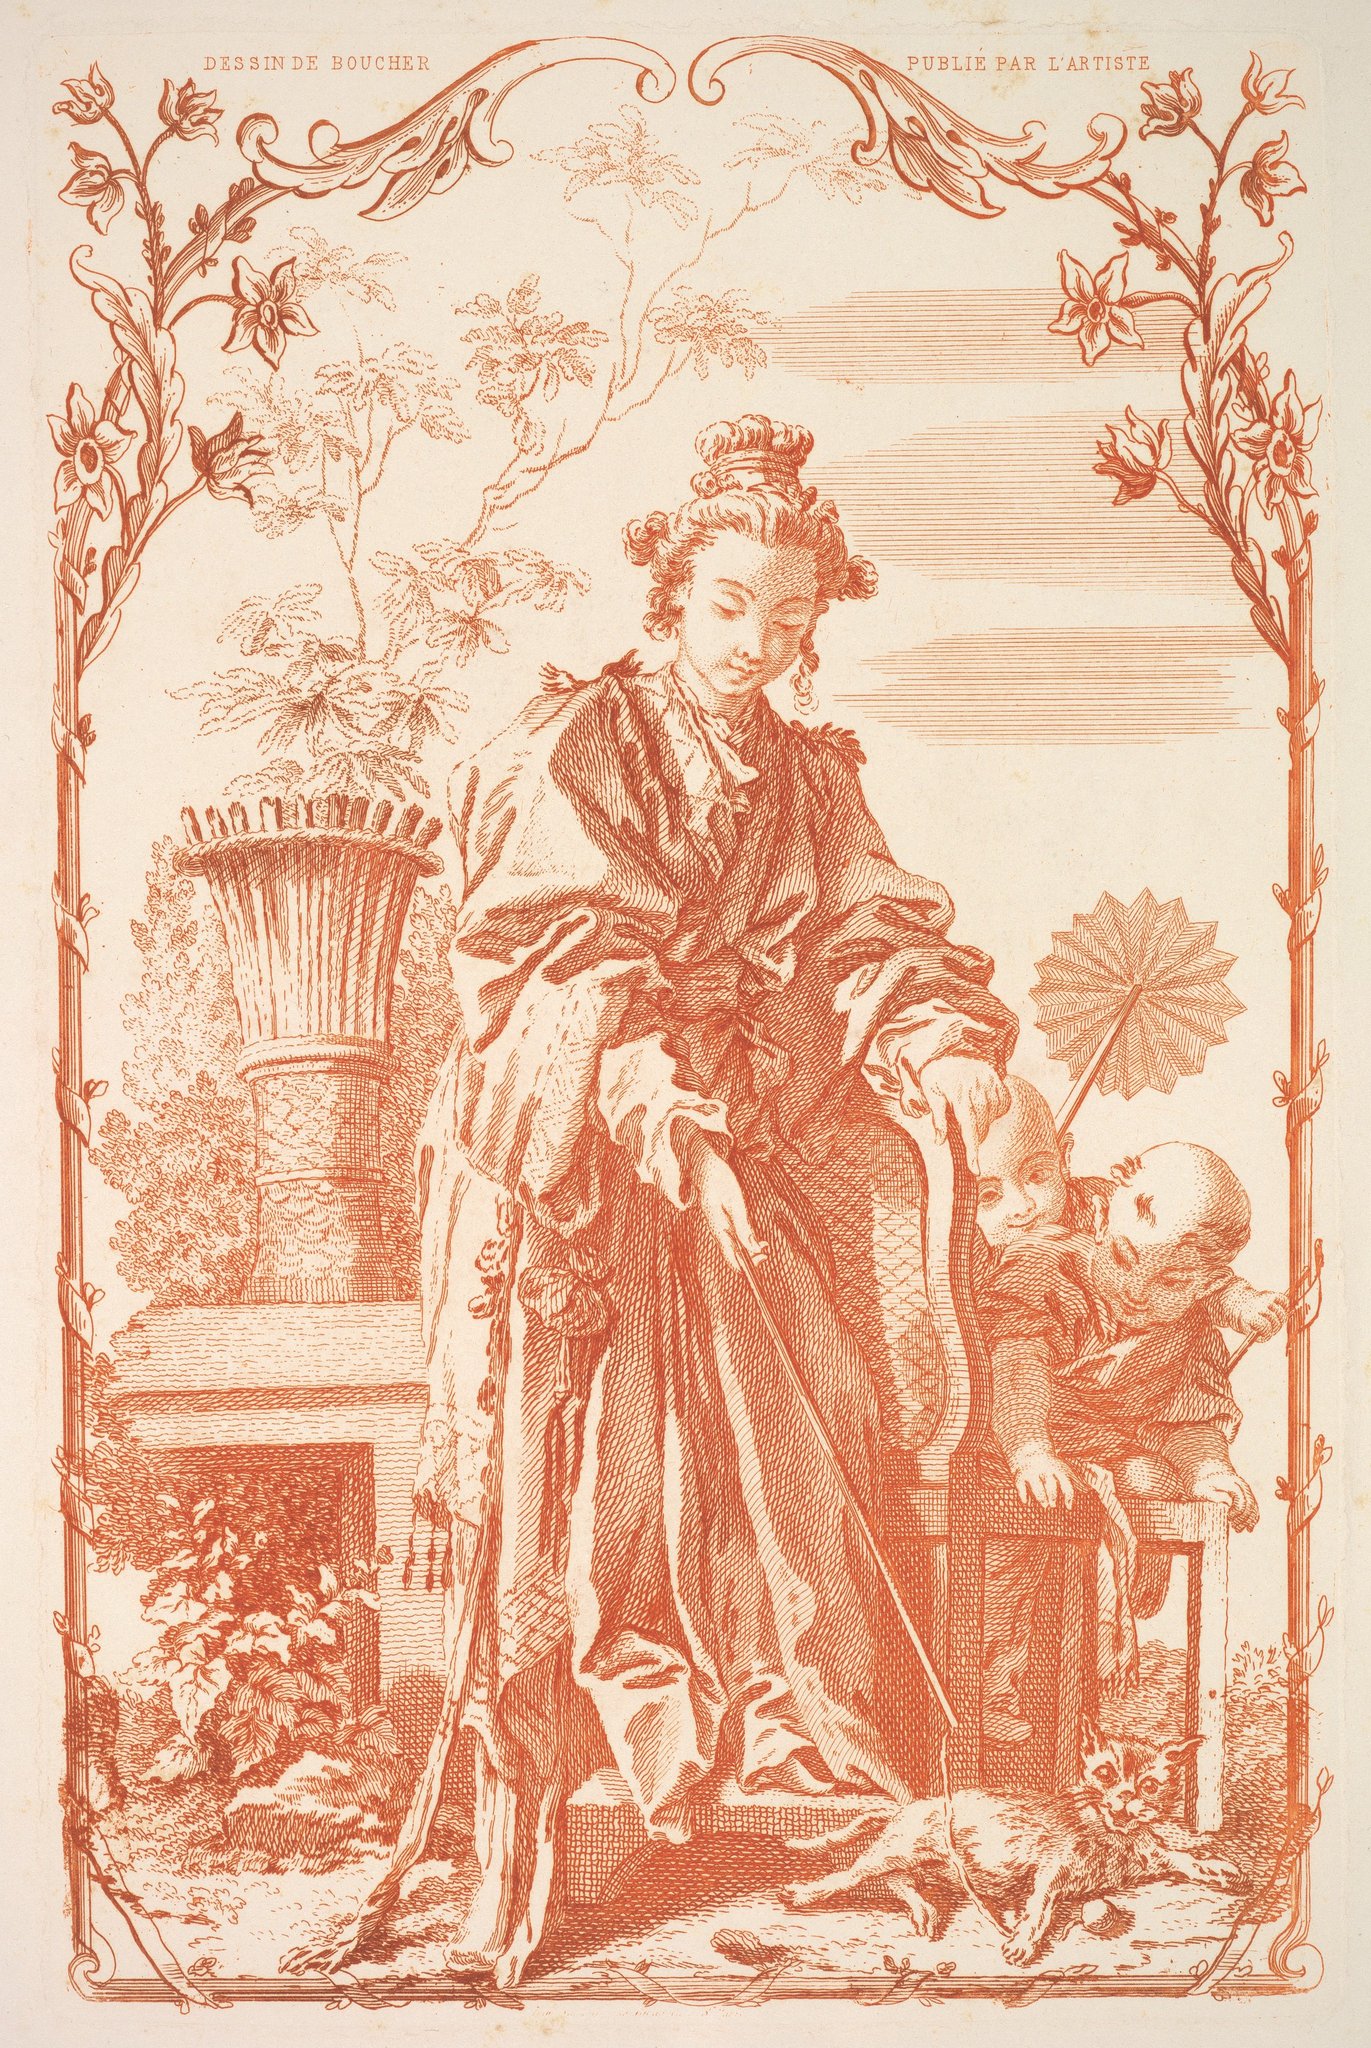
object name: print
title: Woman Playing with a Cat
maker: françois boucher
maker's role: artist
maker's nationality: french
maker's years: 1703-1770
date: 1801-1900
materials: ink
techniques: etching, printing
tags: boys,women,playing,cats